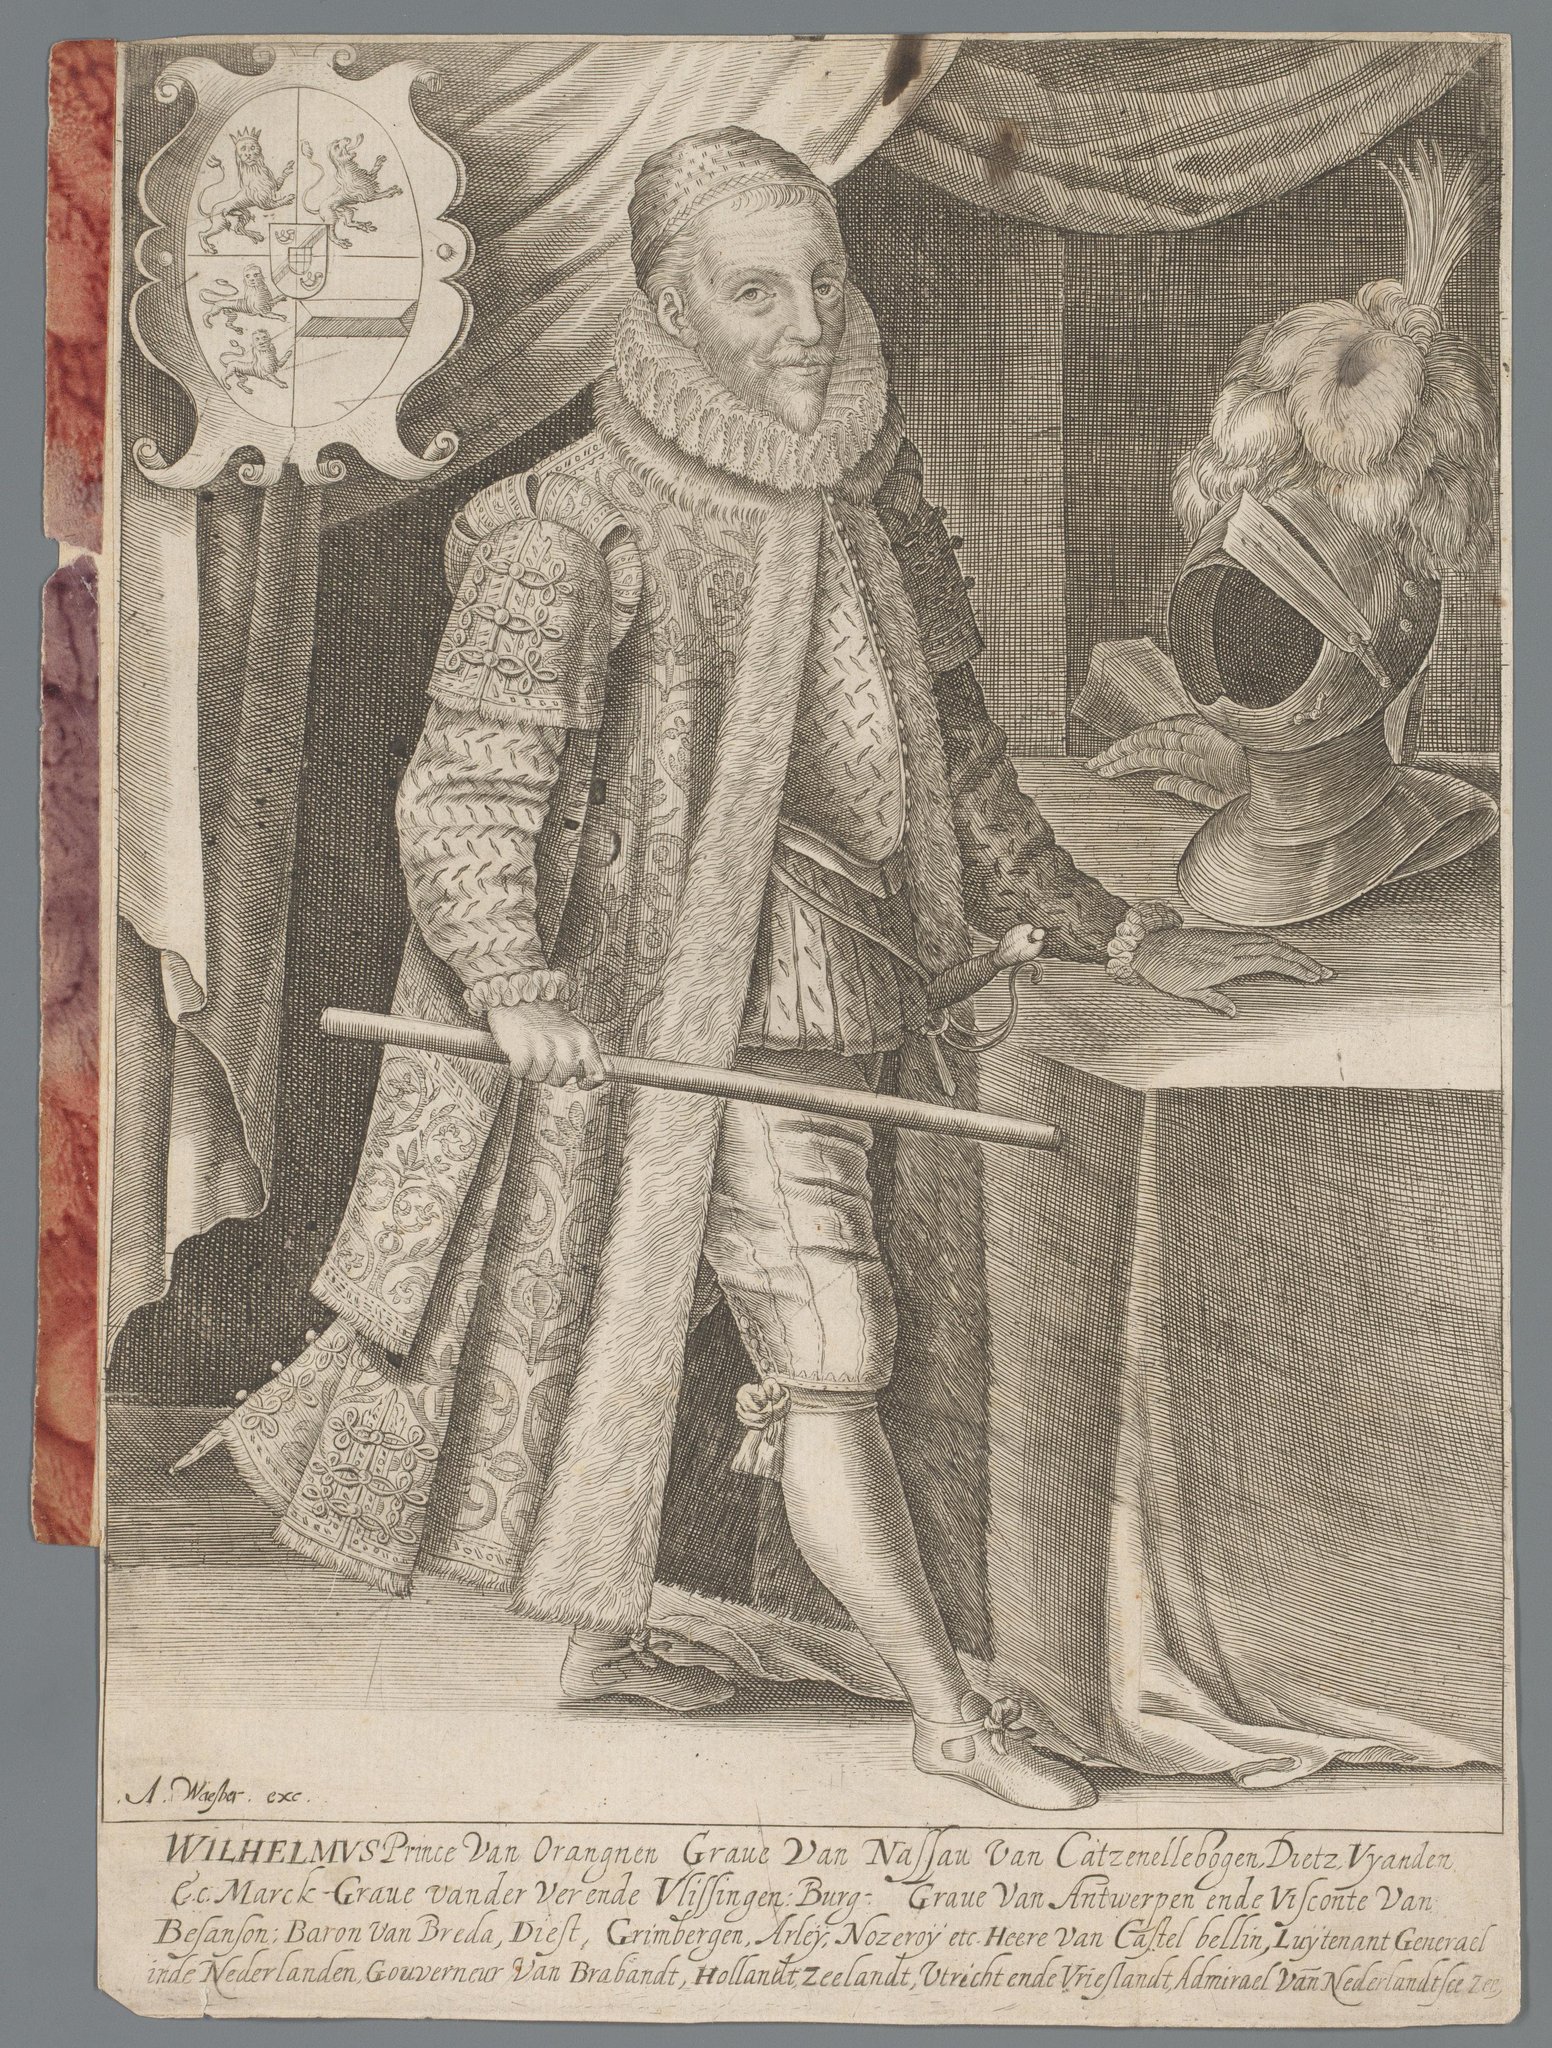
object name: print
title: Portret van Willem I, prins van Oranje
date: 1630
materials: paper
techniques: engraving, etching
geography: low countries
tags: delft, william i (prince of orange), helmet, armour, historical persons, baton of general, armorial bearing, heraldry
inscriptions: collector's mark: ‘Koninkl. Bibliotheek te 's Hage’